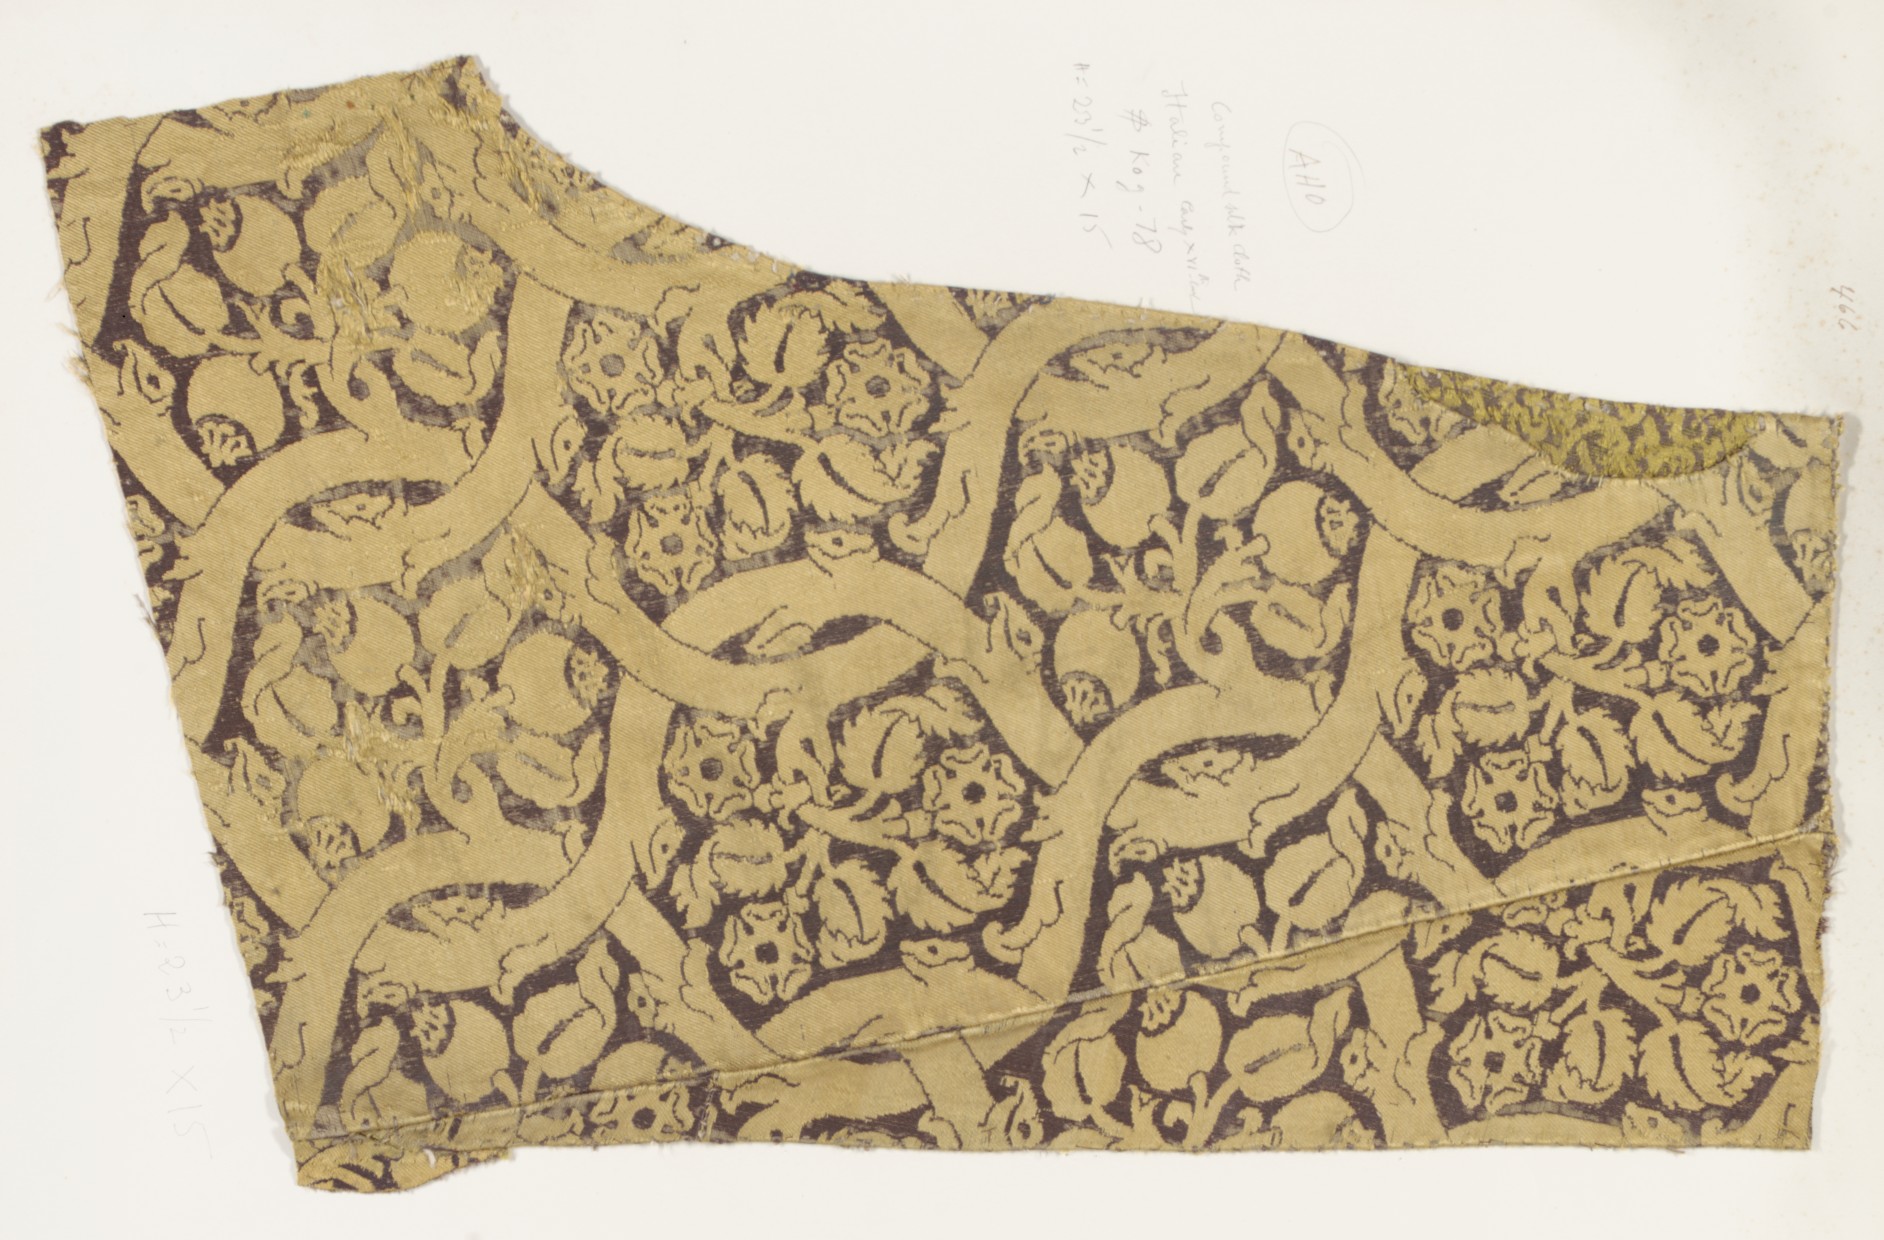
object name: fragment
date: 1501-1533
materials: silk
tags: flowers,leaves